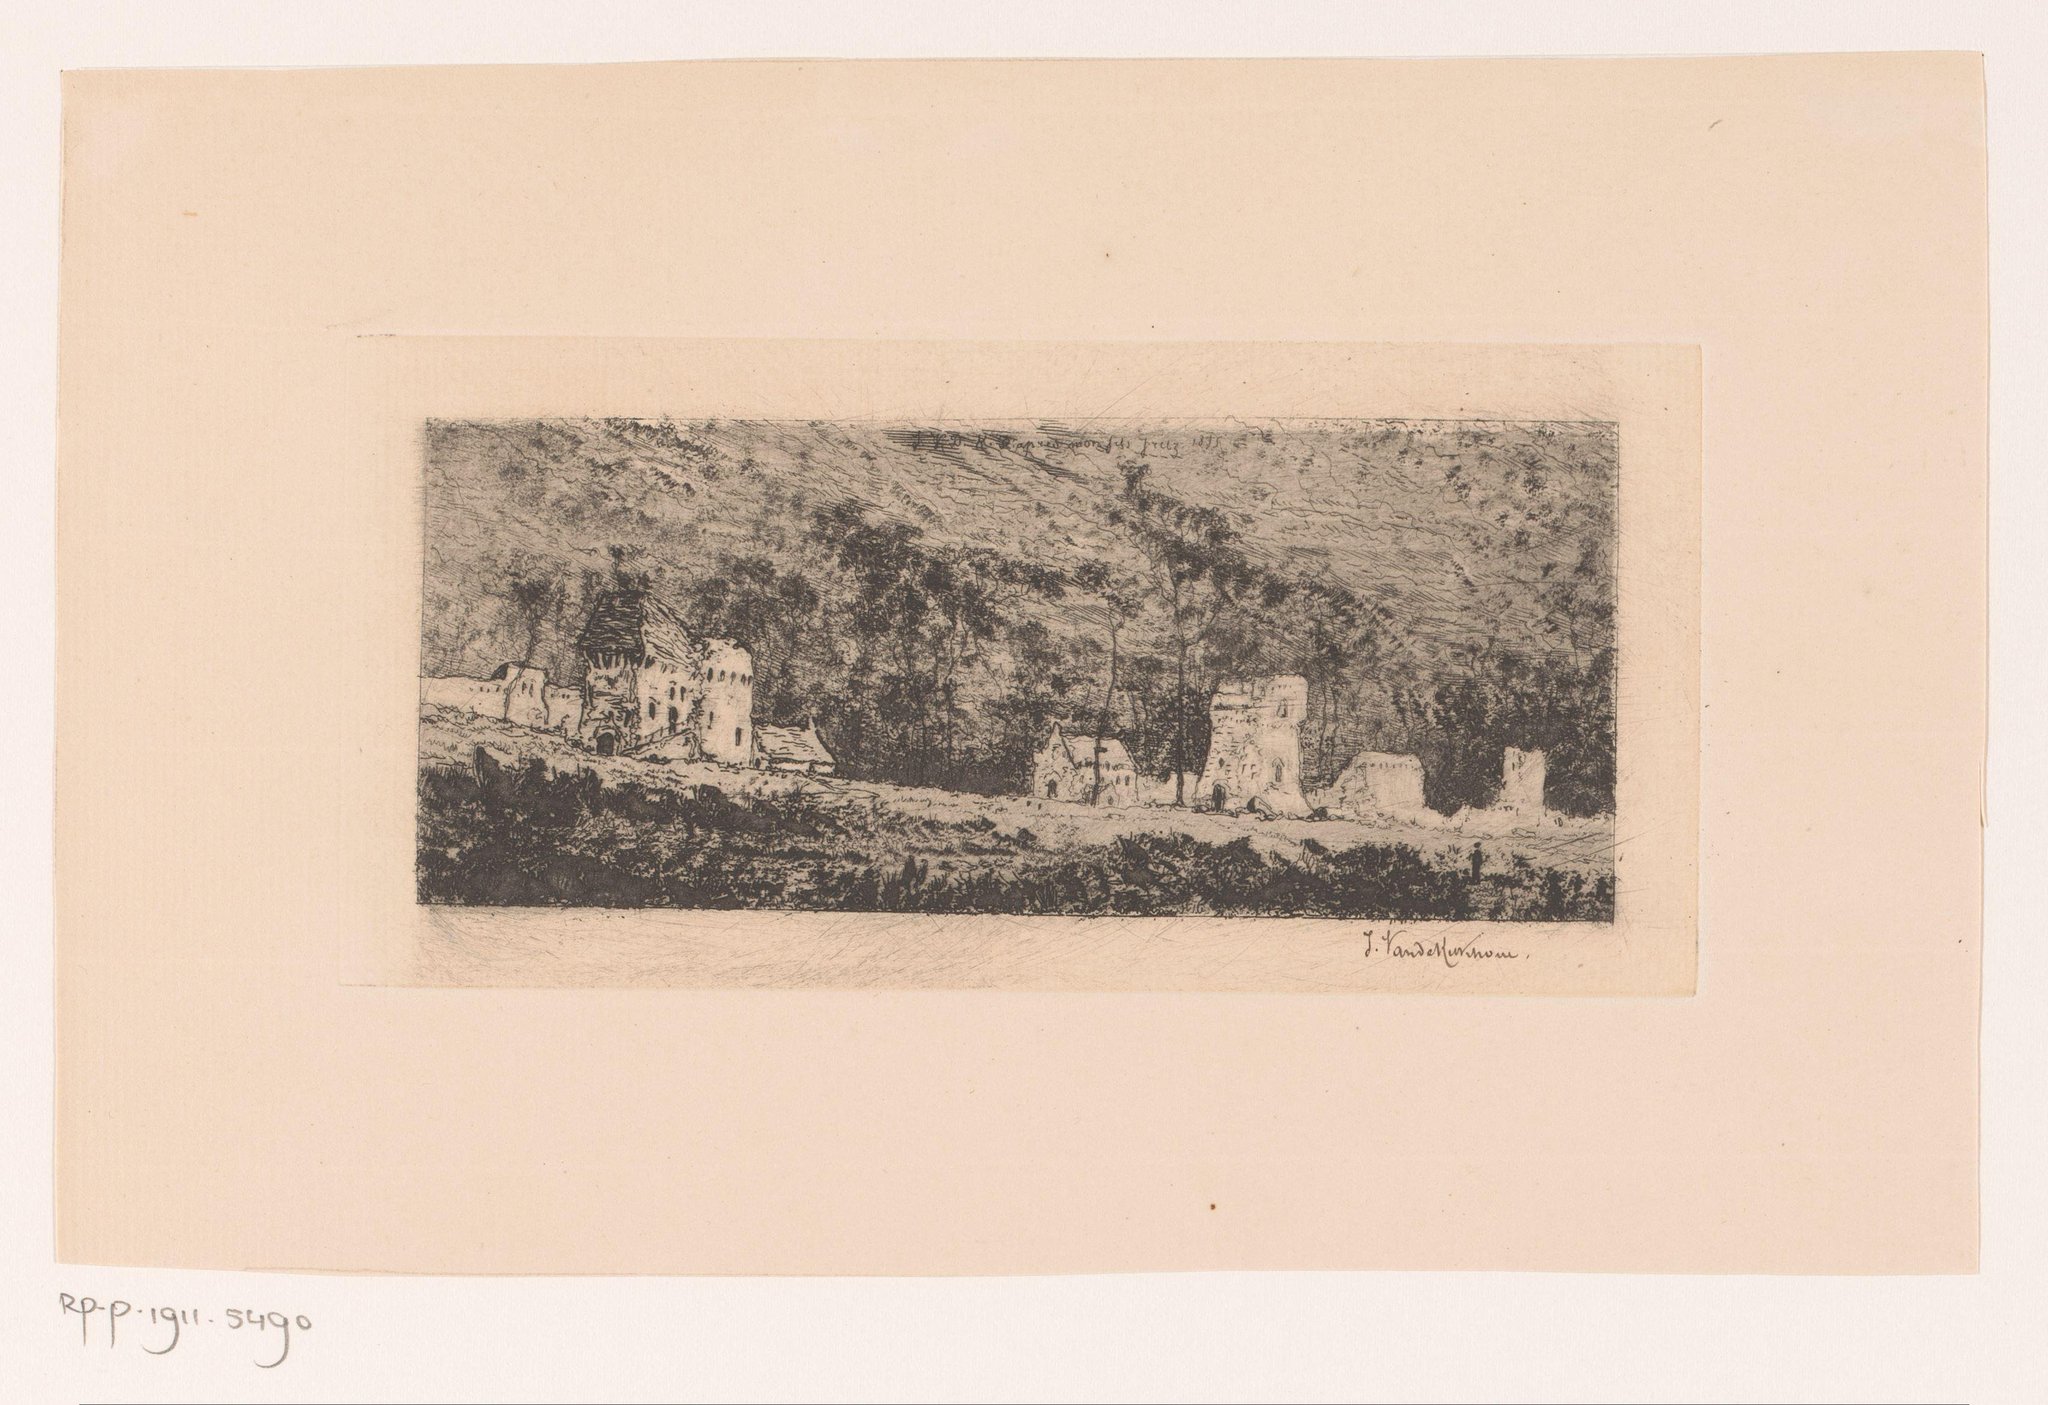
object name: print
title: Rij gebouwen bij ruïne van een kasteelmuur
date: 1875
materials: paper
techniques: etching, intaglio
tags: landscape with tower or castle, ruin of a dwelling, house, castle, etc.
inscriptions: collector's mark: Lugt 2228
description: De etsen naar de schilderijen van Frédéric Van de Kerkhove werden na zijn dood door zijn vader en zuster gemaakt en uitgegeven in twee reeksen. De eerste werd in 1877 uitgegeven door het Journal des Beaux-Arts et de la Littérature: Cahier de 25 Eaux-fortes d'après Frédéric van de Kerkhove, gravées par son père et sa sœur. De tweede reeks van 126 etsen, ook in 1877, werd in Parijs uitgegeven bij A. Lévy onder de titel Cent eaux-fortes gravées par J. Van de Kerkhove d'après les tableaux de Frédéric Van de Kerkhove, mort en 1873 à l'âge de 10 ans et 11 mois.